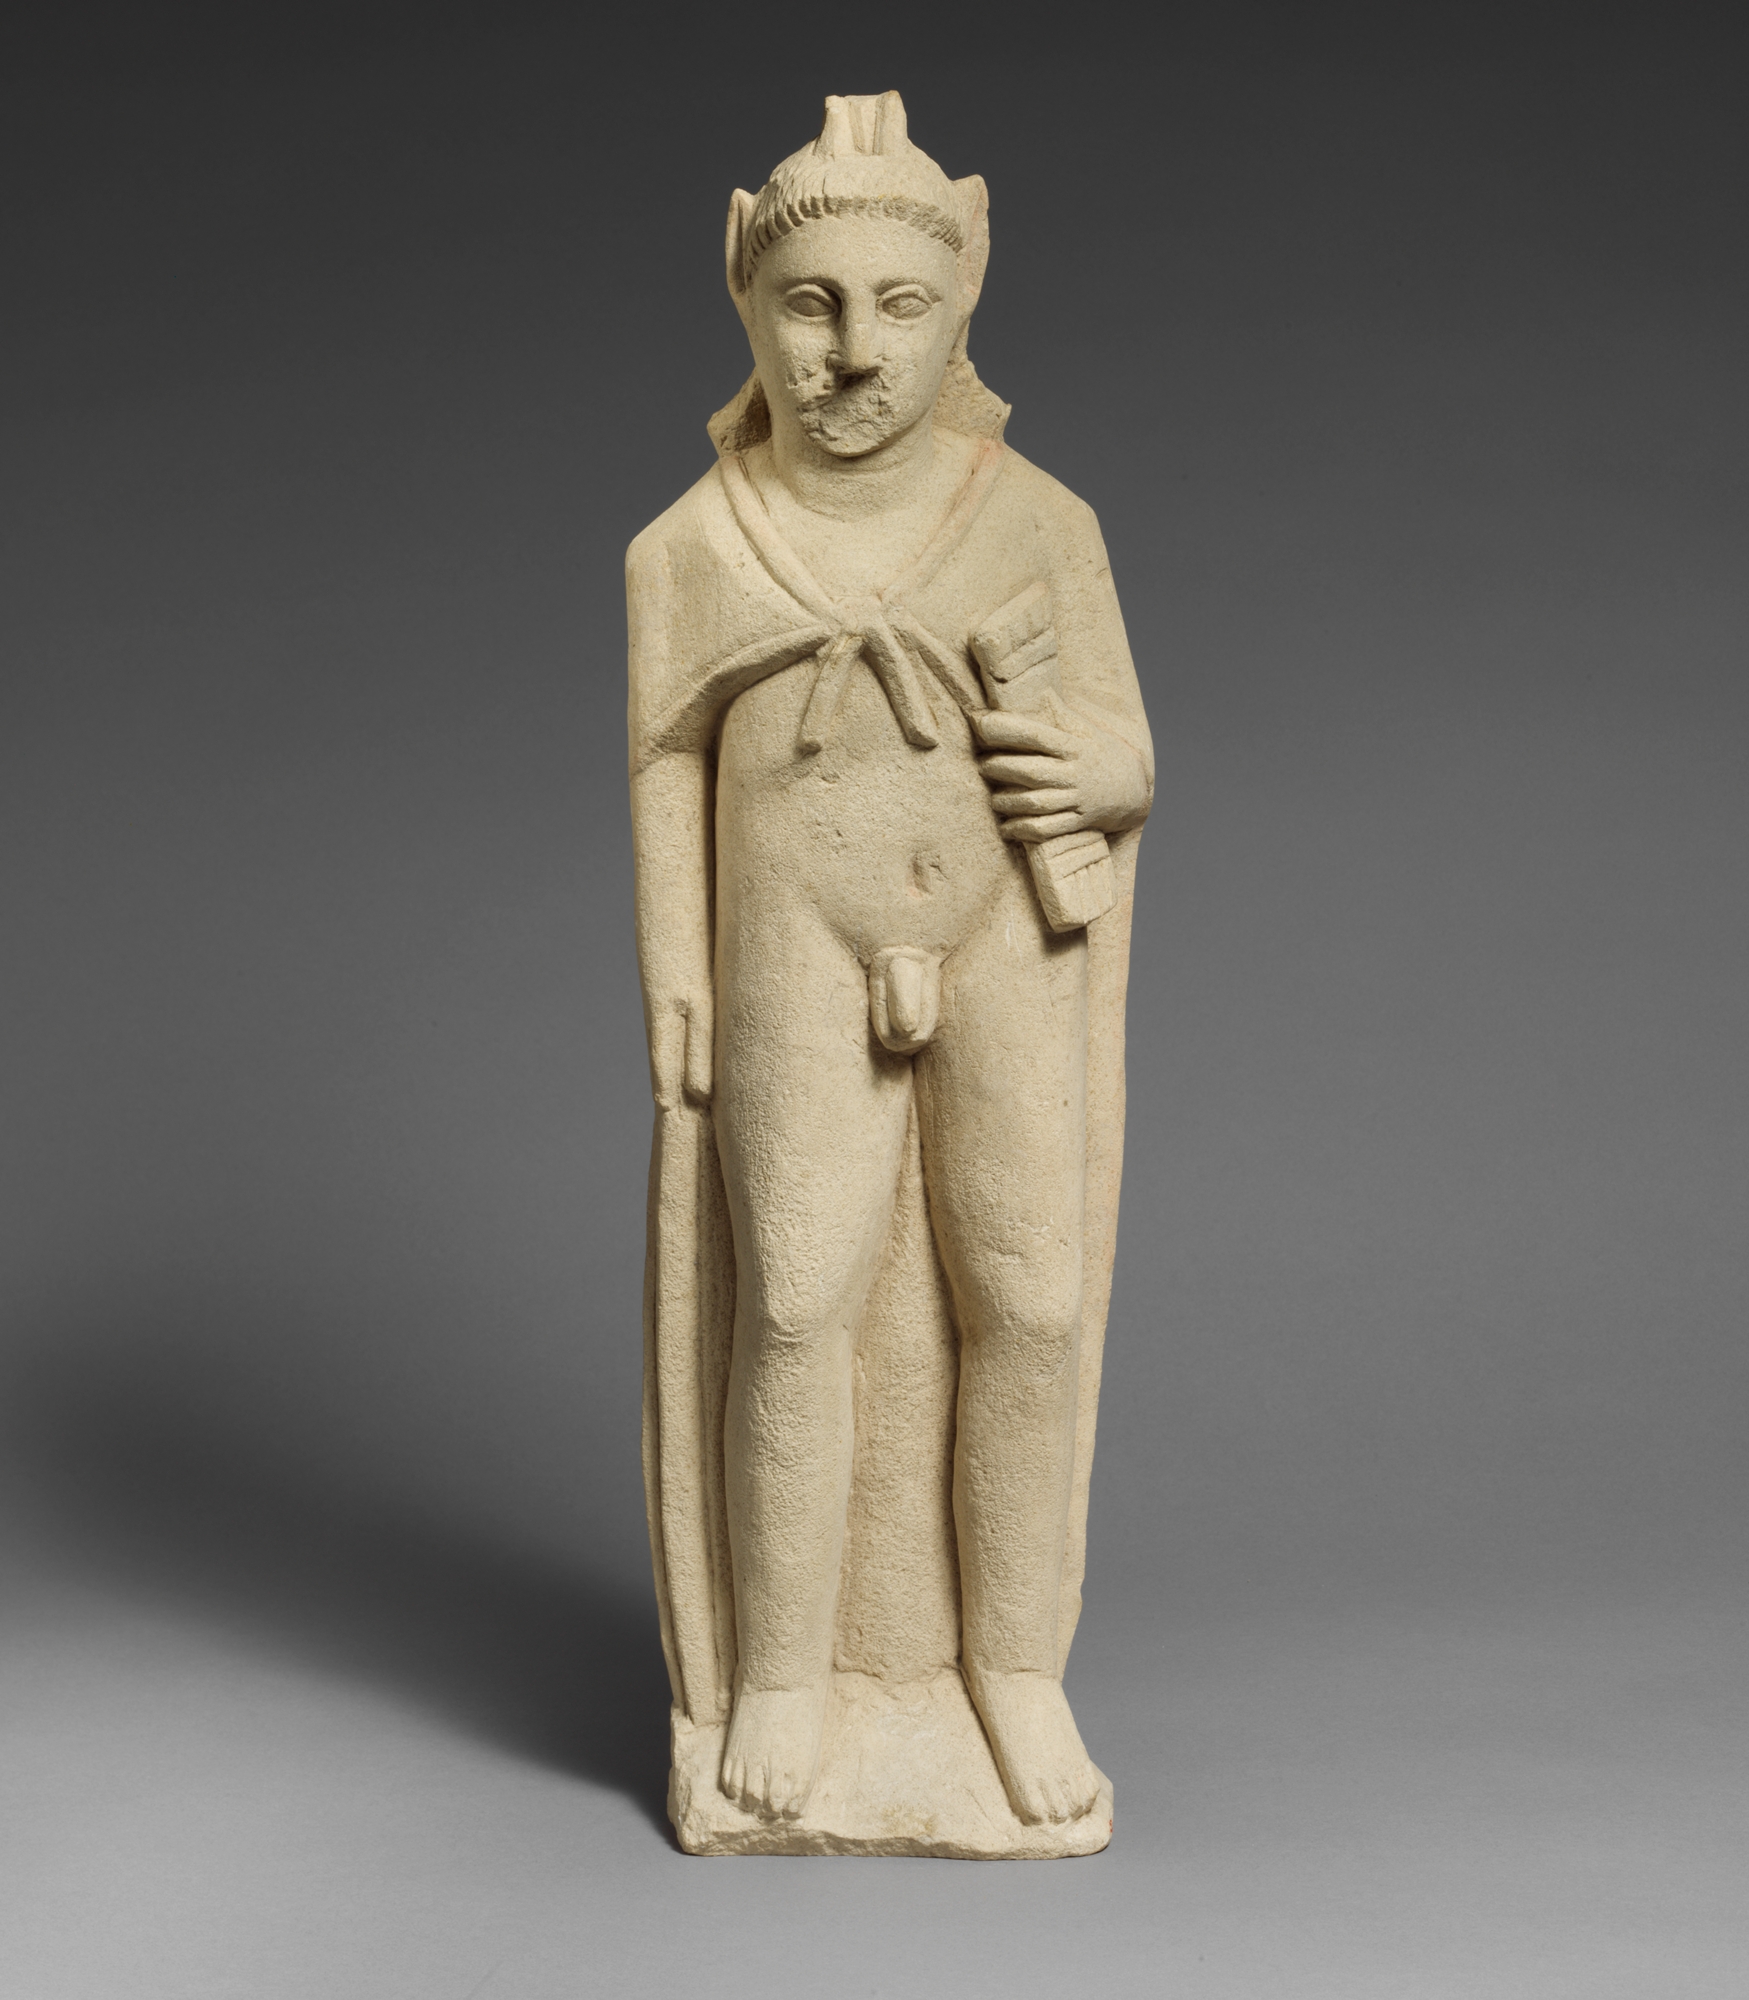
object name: statue of pan or melanthios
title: Limestone statuette of Pan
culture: cypriot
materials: limestone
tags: male nudes